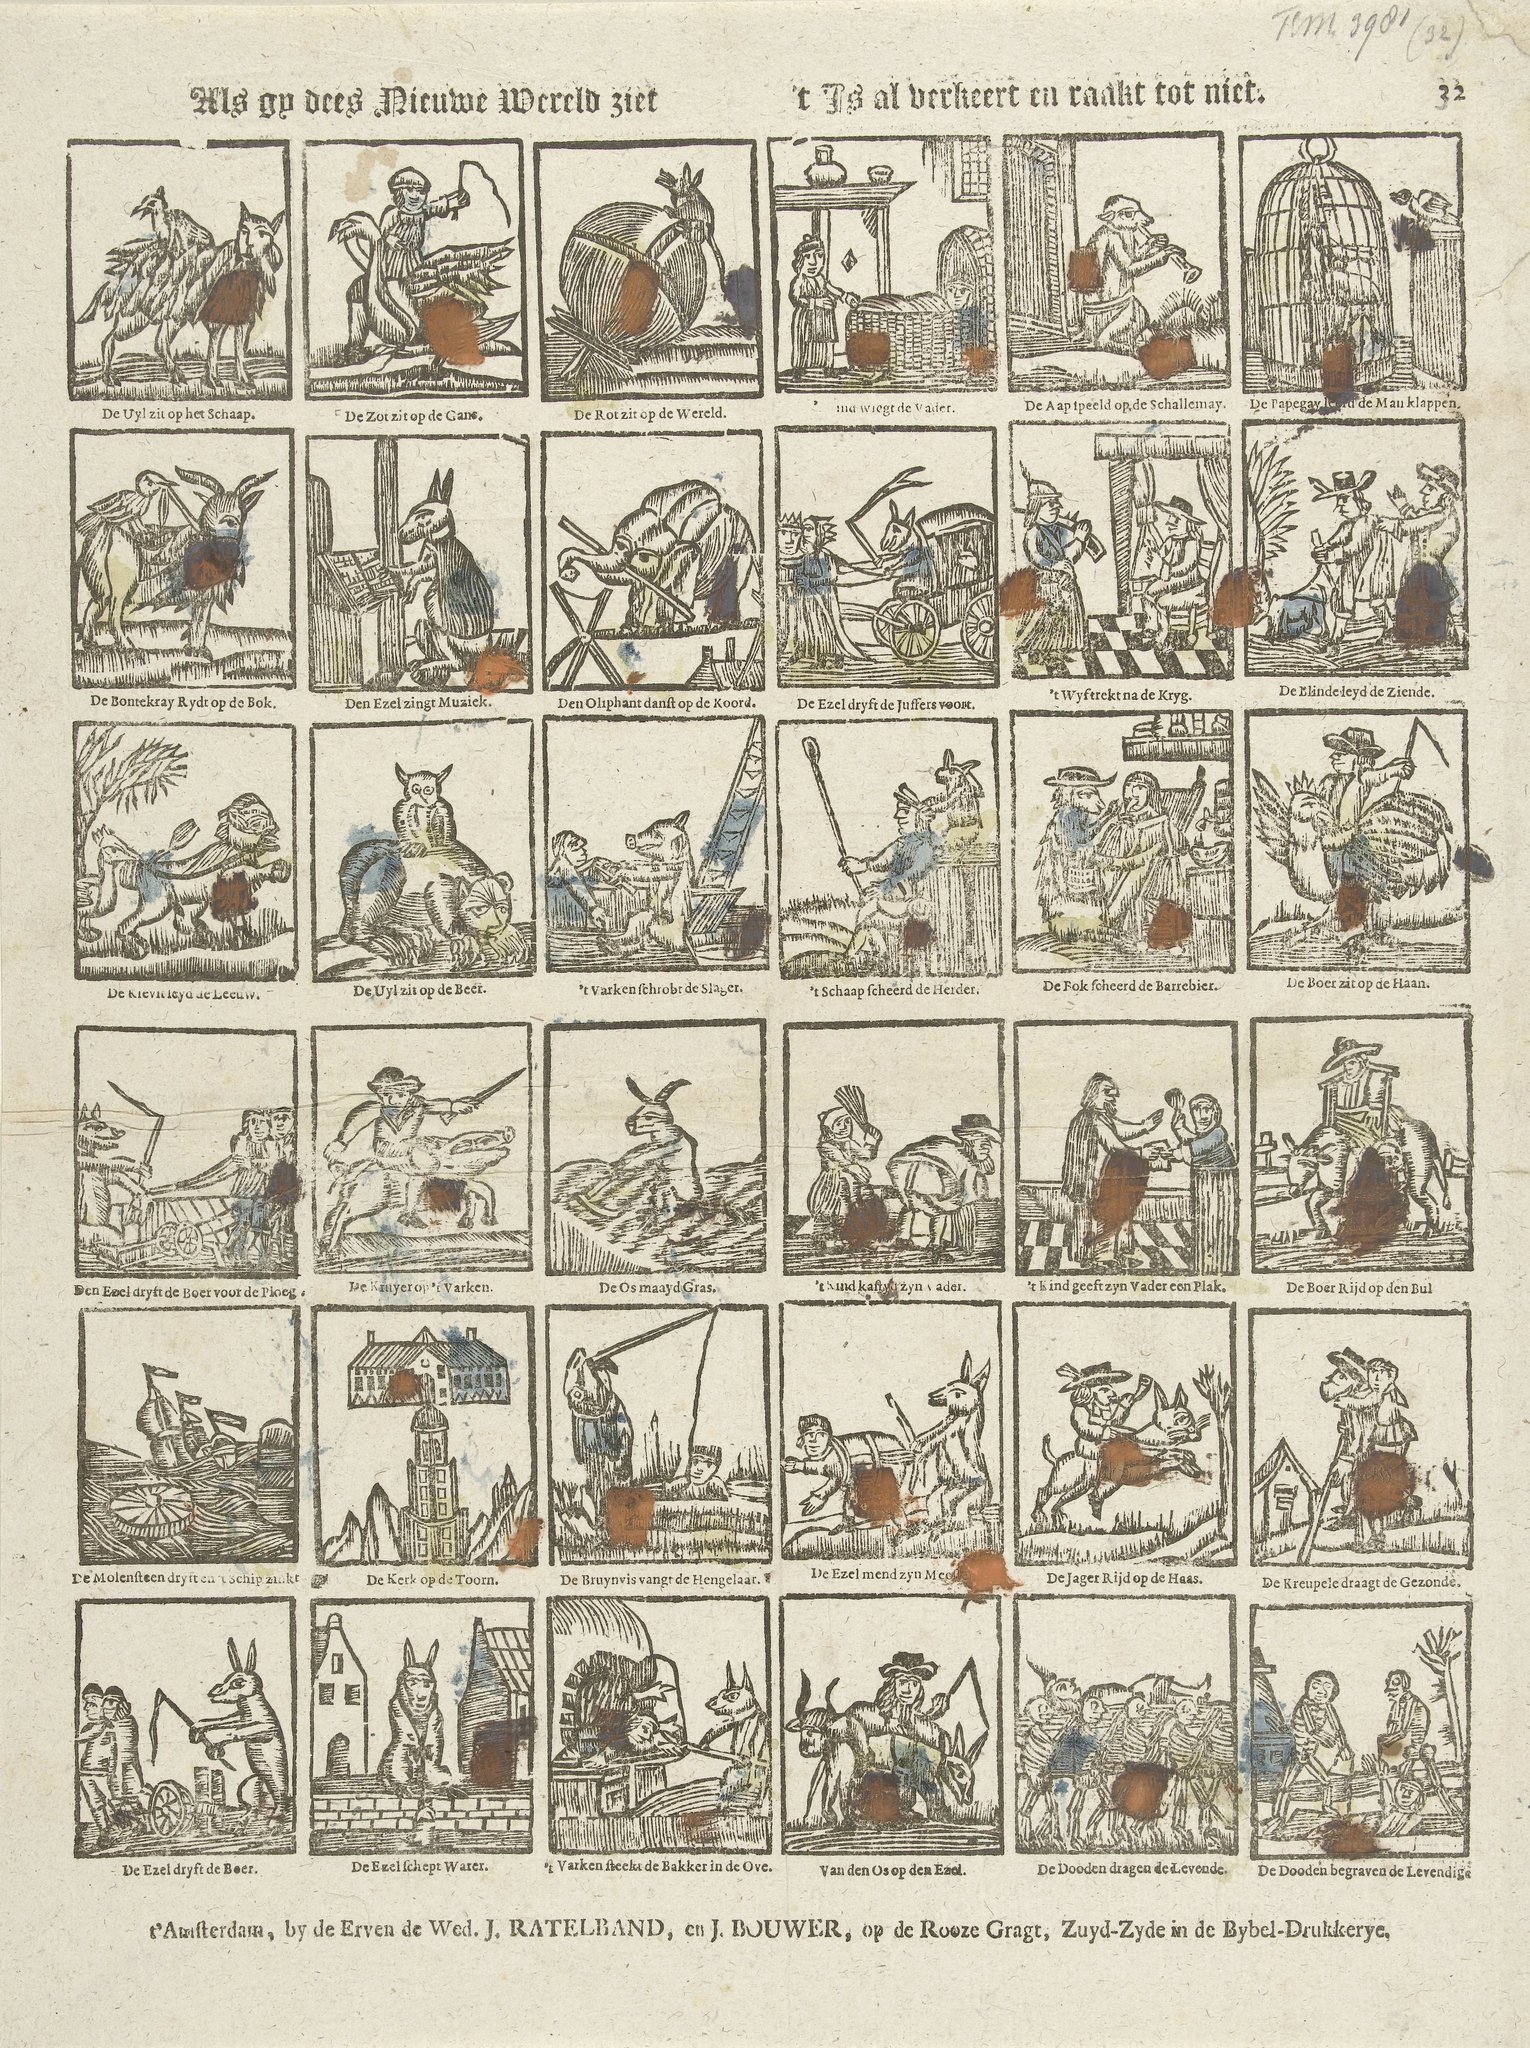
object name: print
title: Als gy dees nieuwe wereld ziet / 't Is al verkeert en raakt tot niet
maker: Anonymous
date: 1782-1793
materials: paper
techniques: colour, letterpress printing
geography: amsterdam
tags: 'mundus inversus', the reversed world, the topsy-turvy world, 'le monde bestourné'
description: Blad met 36 voorstellingen van de verkeerde wereld.Onder elke afbeelding een eenregelig onderschrift. Genummerd rechtsboven: 32.